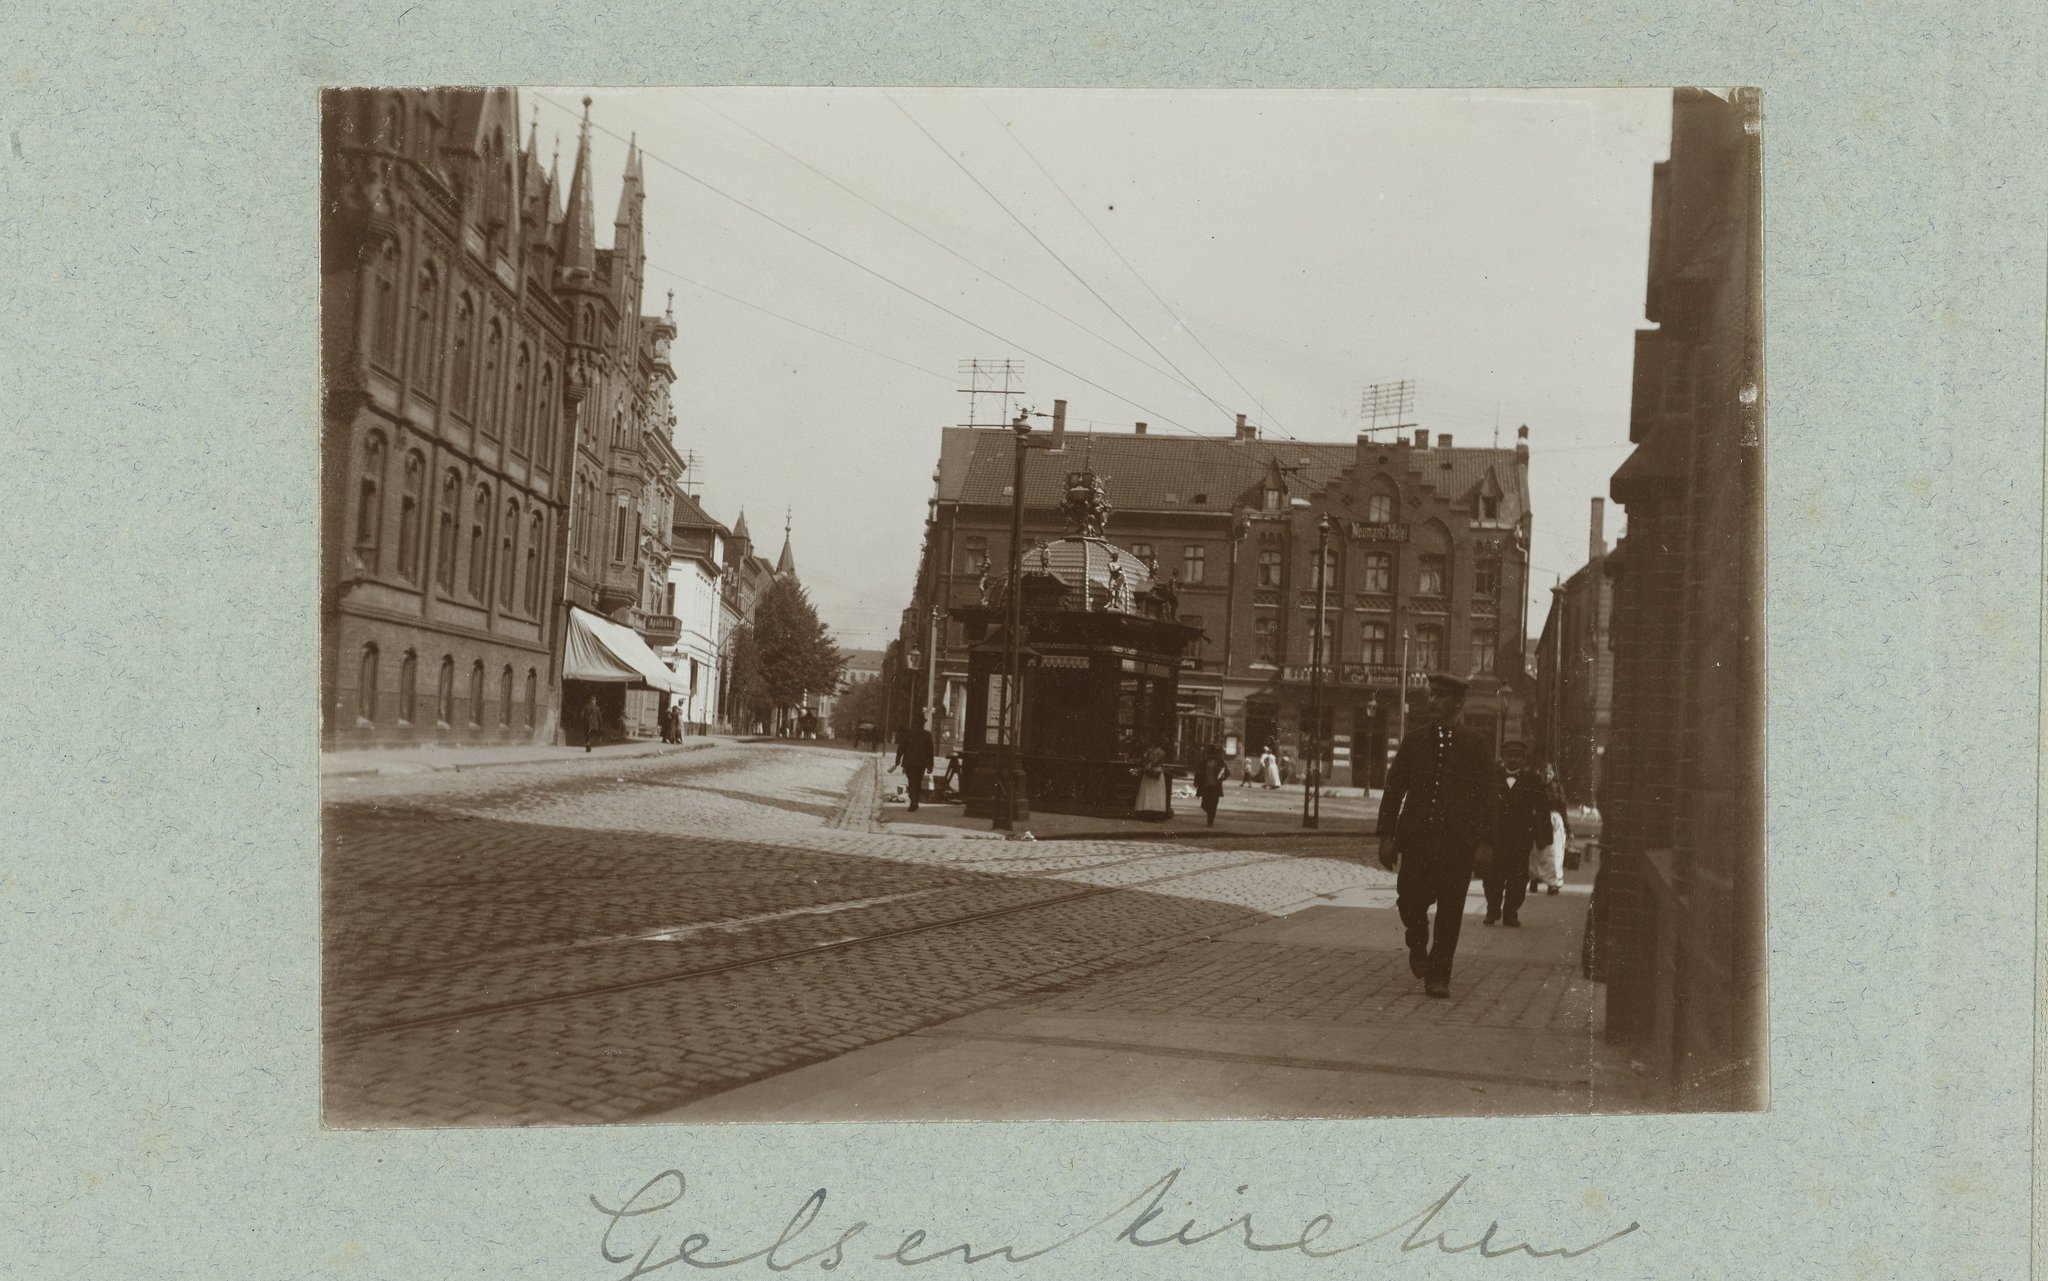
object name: photograph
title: Photographieën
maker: frits freerks fontein fz.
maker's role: fotograaf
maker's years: 1882-1928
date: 1902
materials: cardboard, paper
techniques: gelatin silver print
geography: netherlands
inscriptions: caption: ‘Gelsenkirchen 1902’